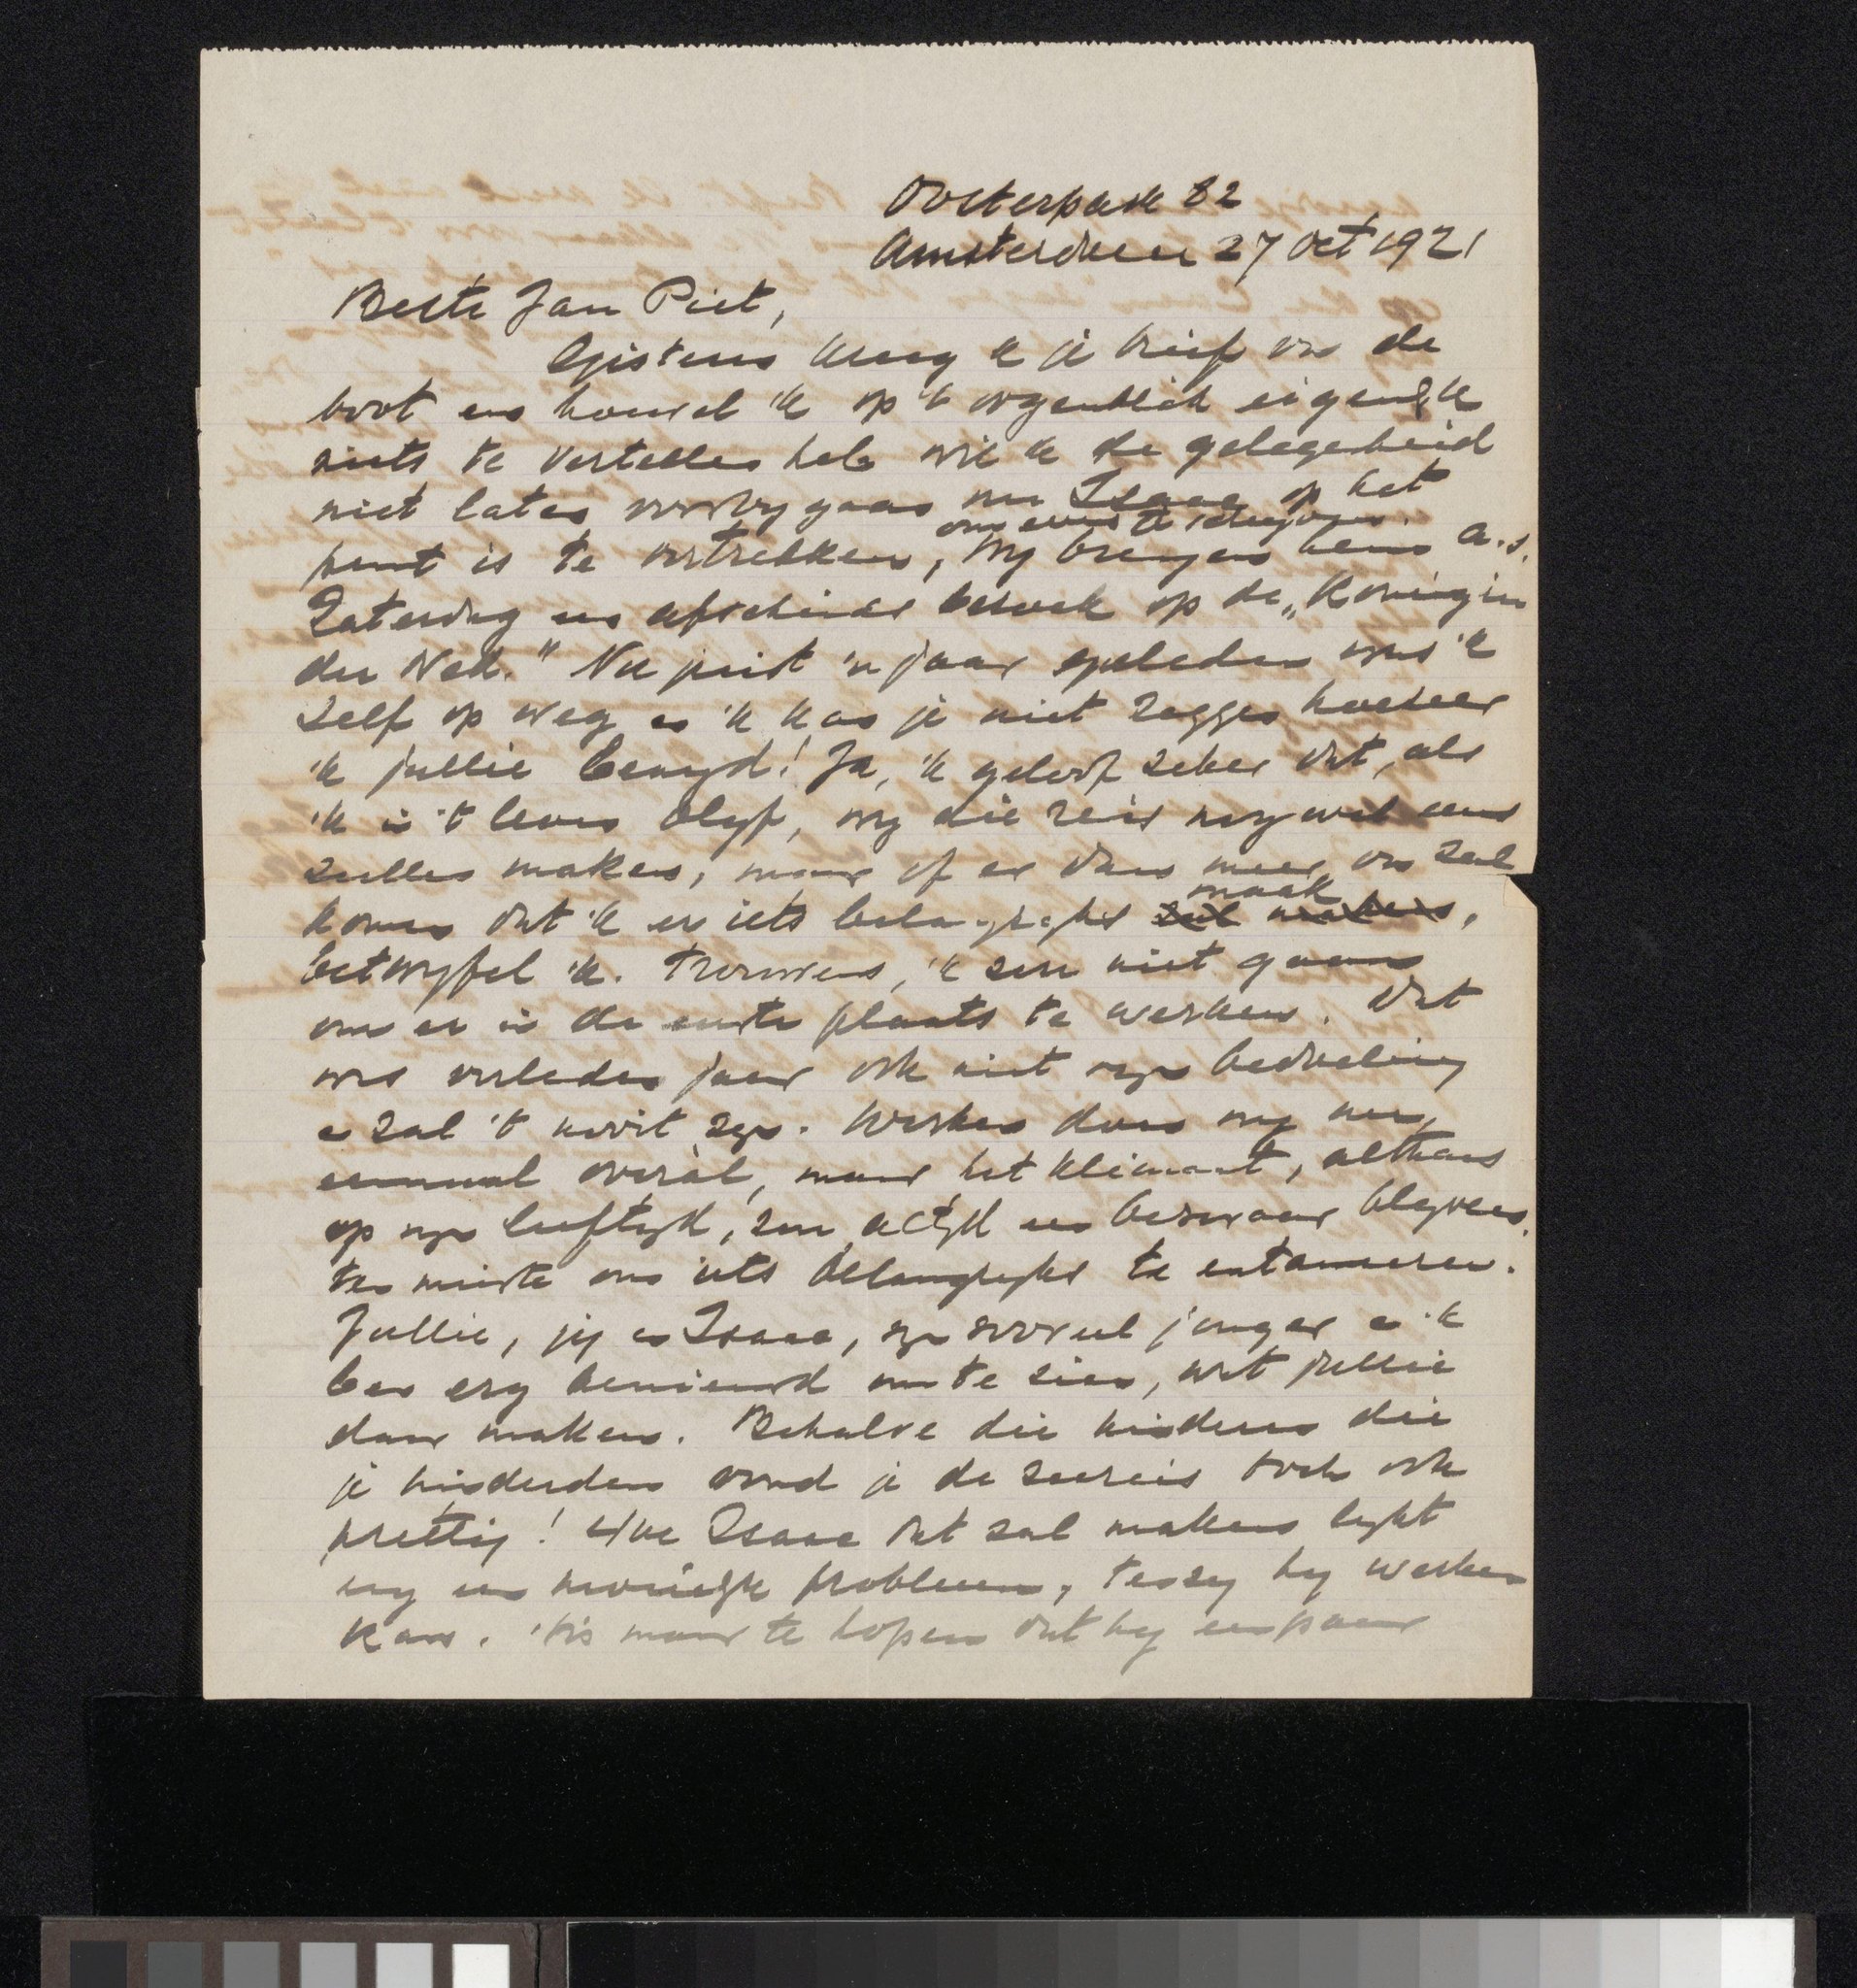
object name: letter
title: Brief aan Jan Veth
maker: willem witsen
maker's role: draughtsman, painter, print maker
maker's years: 1860-1923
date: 1921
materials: ink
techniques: pen, writing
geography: amsterdam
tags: dordrecht, designer, jan veth, the hague, isaac israels, travelling; tourism, diseases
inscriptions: collector's mark: ‘RPK’